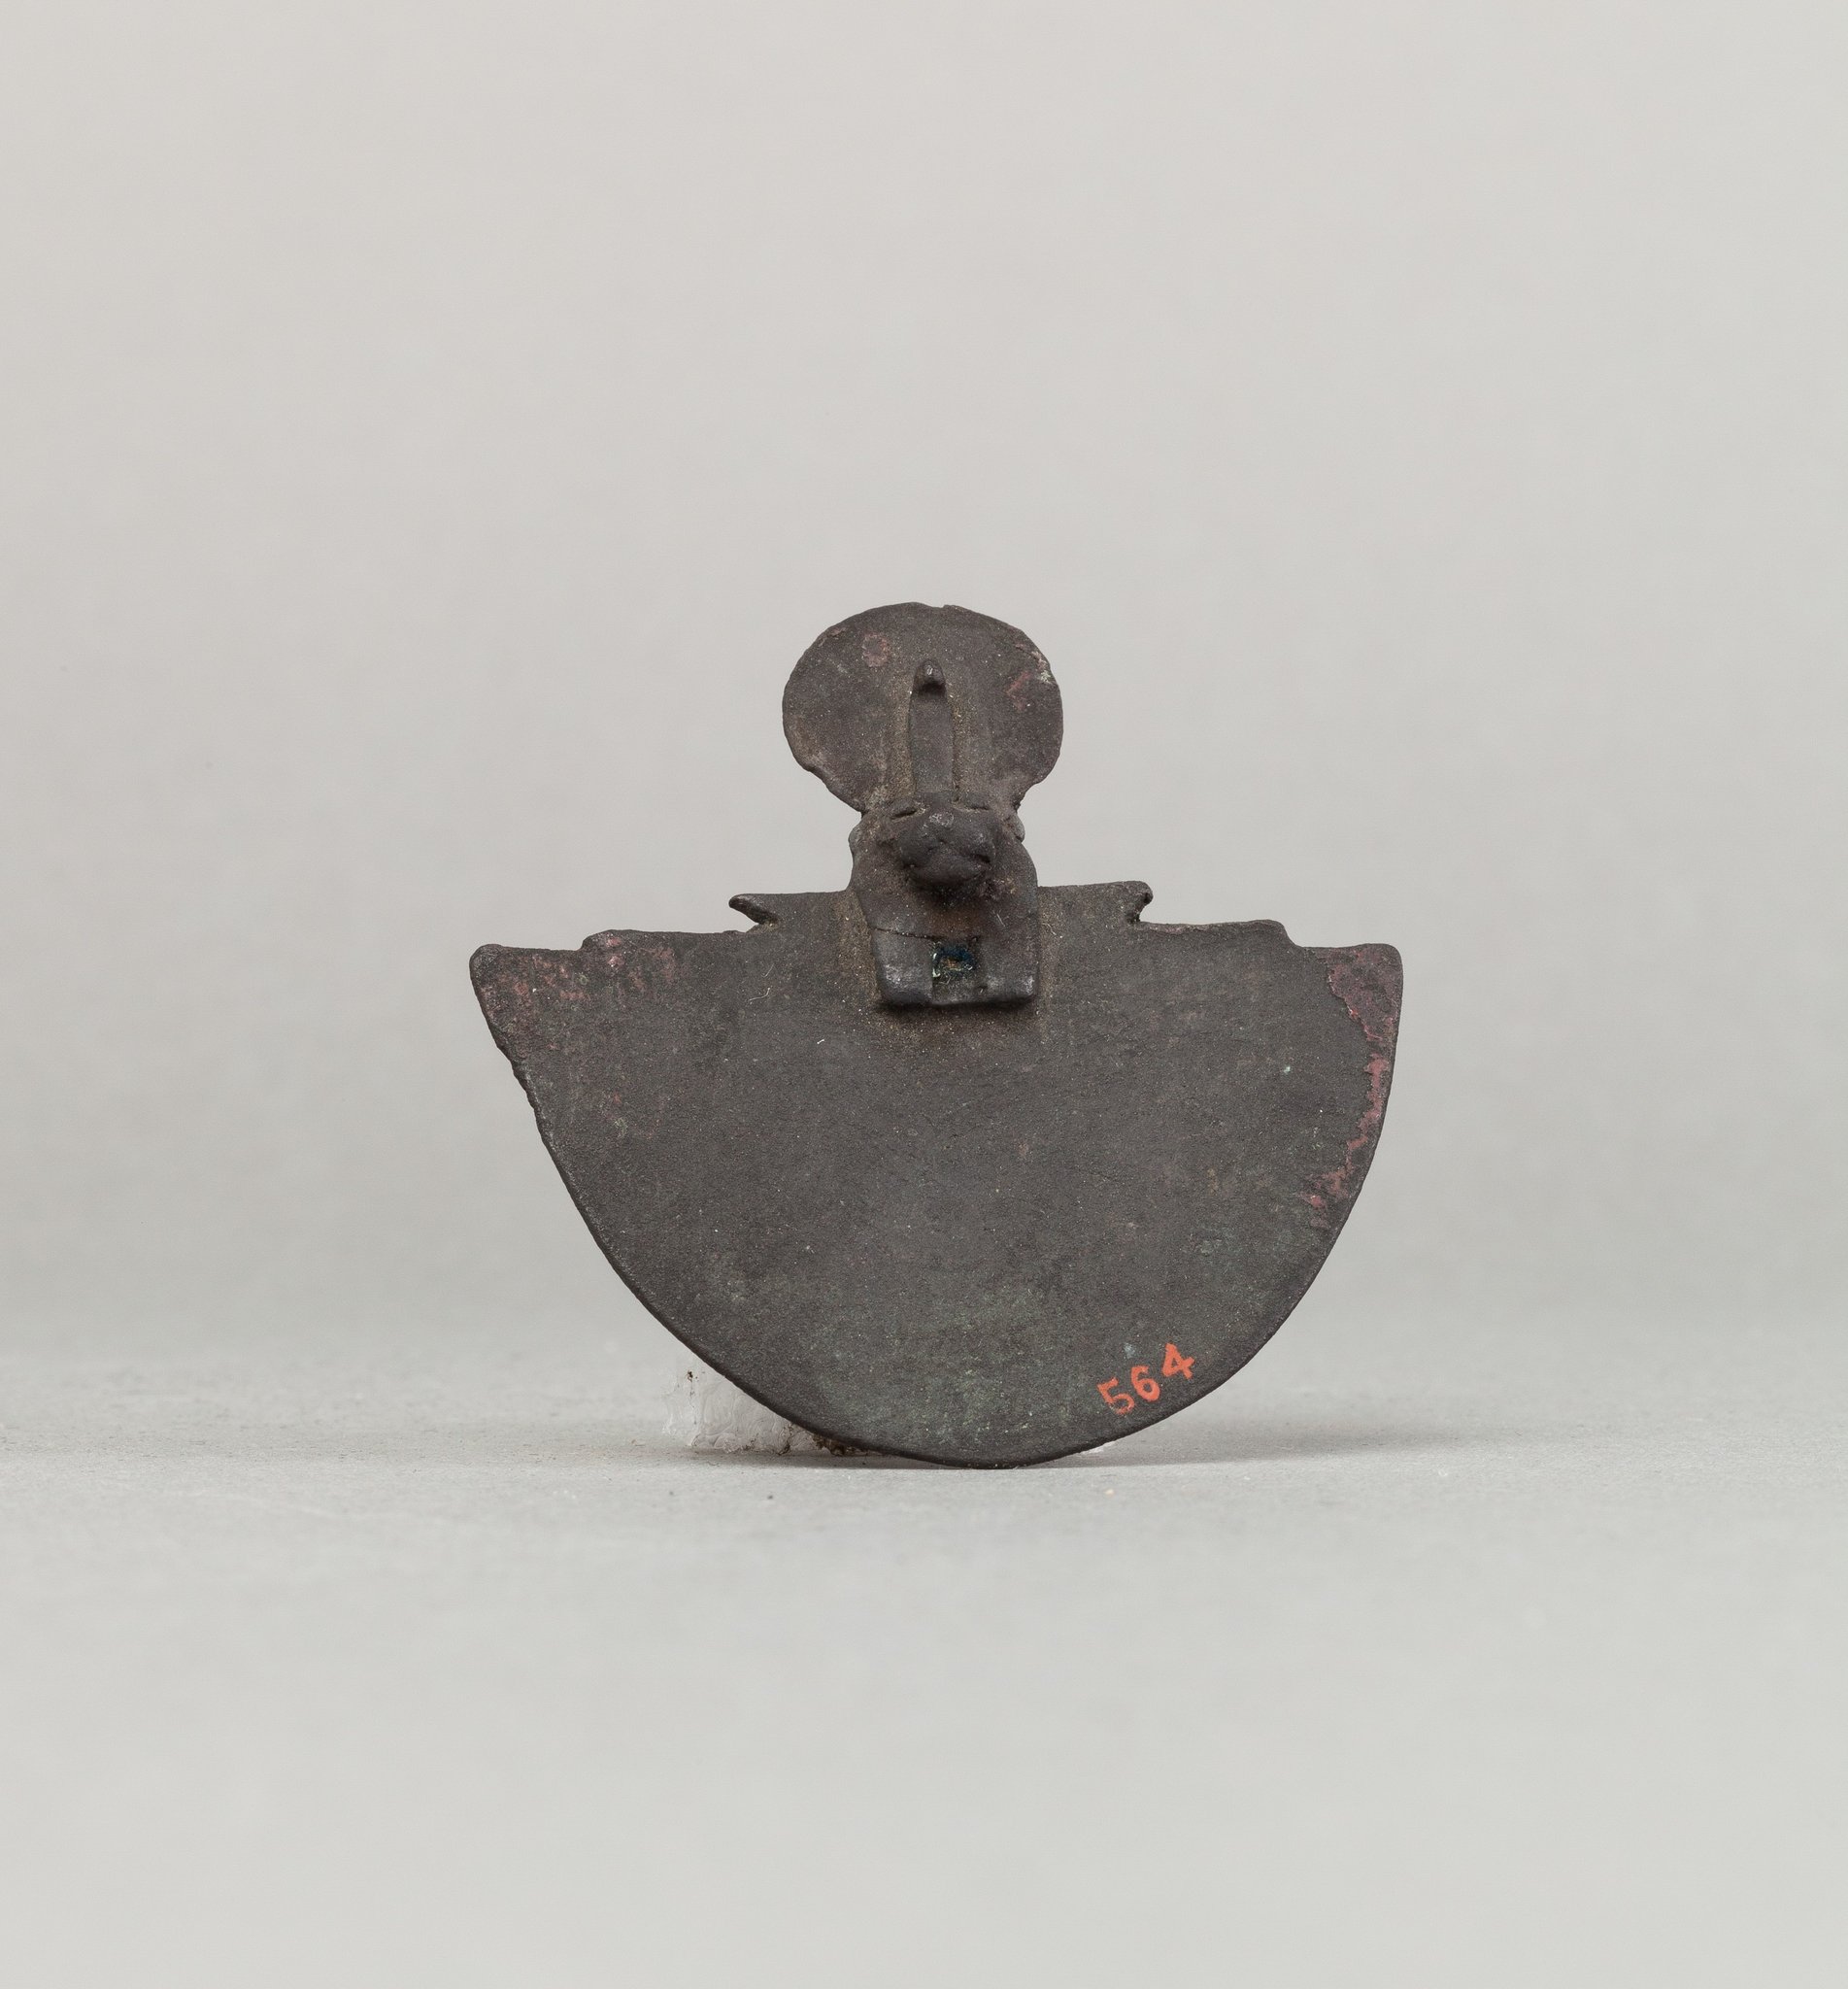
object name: amulet, aegis, bastet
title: Aegis of Bastet / Sakhmet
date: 664-630 BCE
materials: metal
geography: egypt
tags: sekhmet